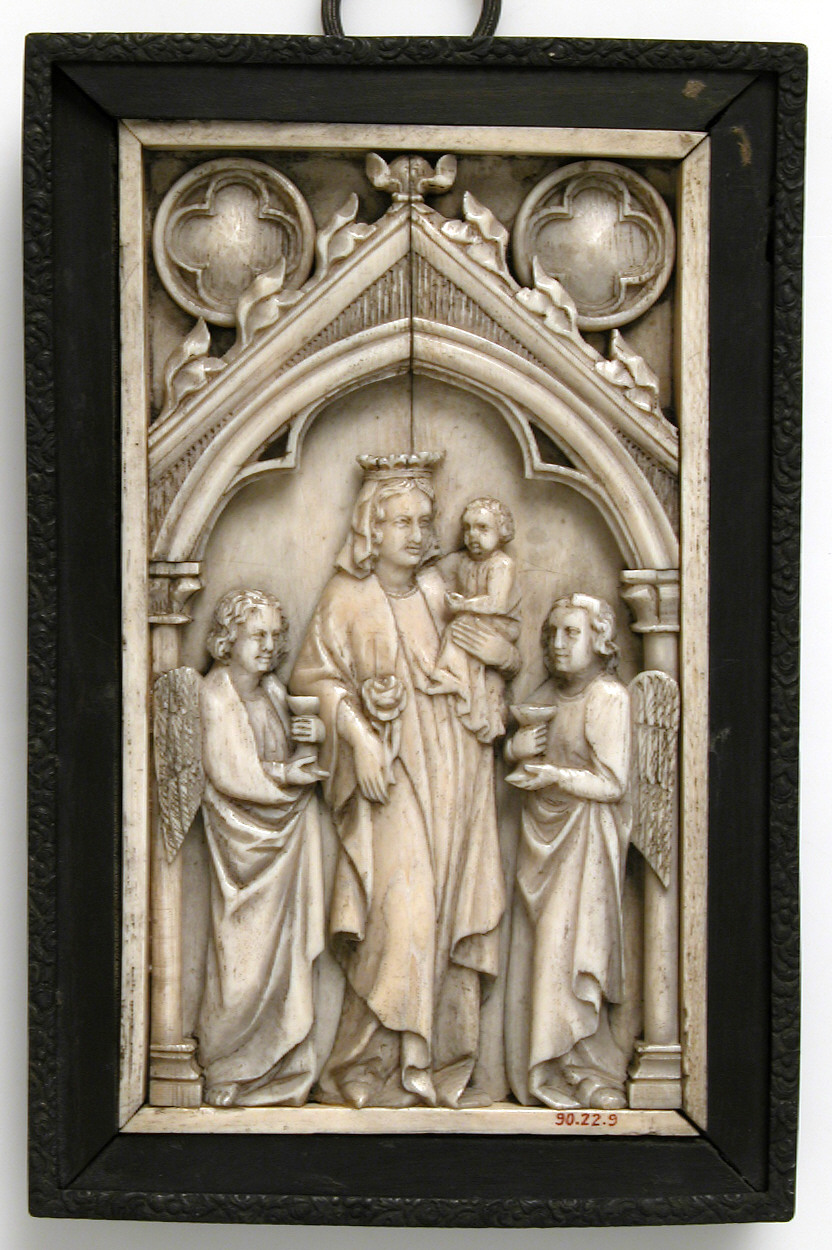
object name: panel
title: Panel with Virgin and Child with Angels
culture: european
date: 1801-1900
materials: ivory, silver, wood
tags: virgin mary,jesus